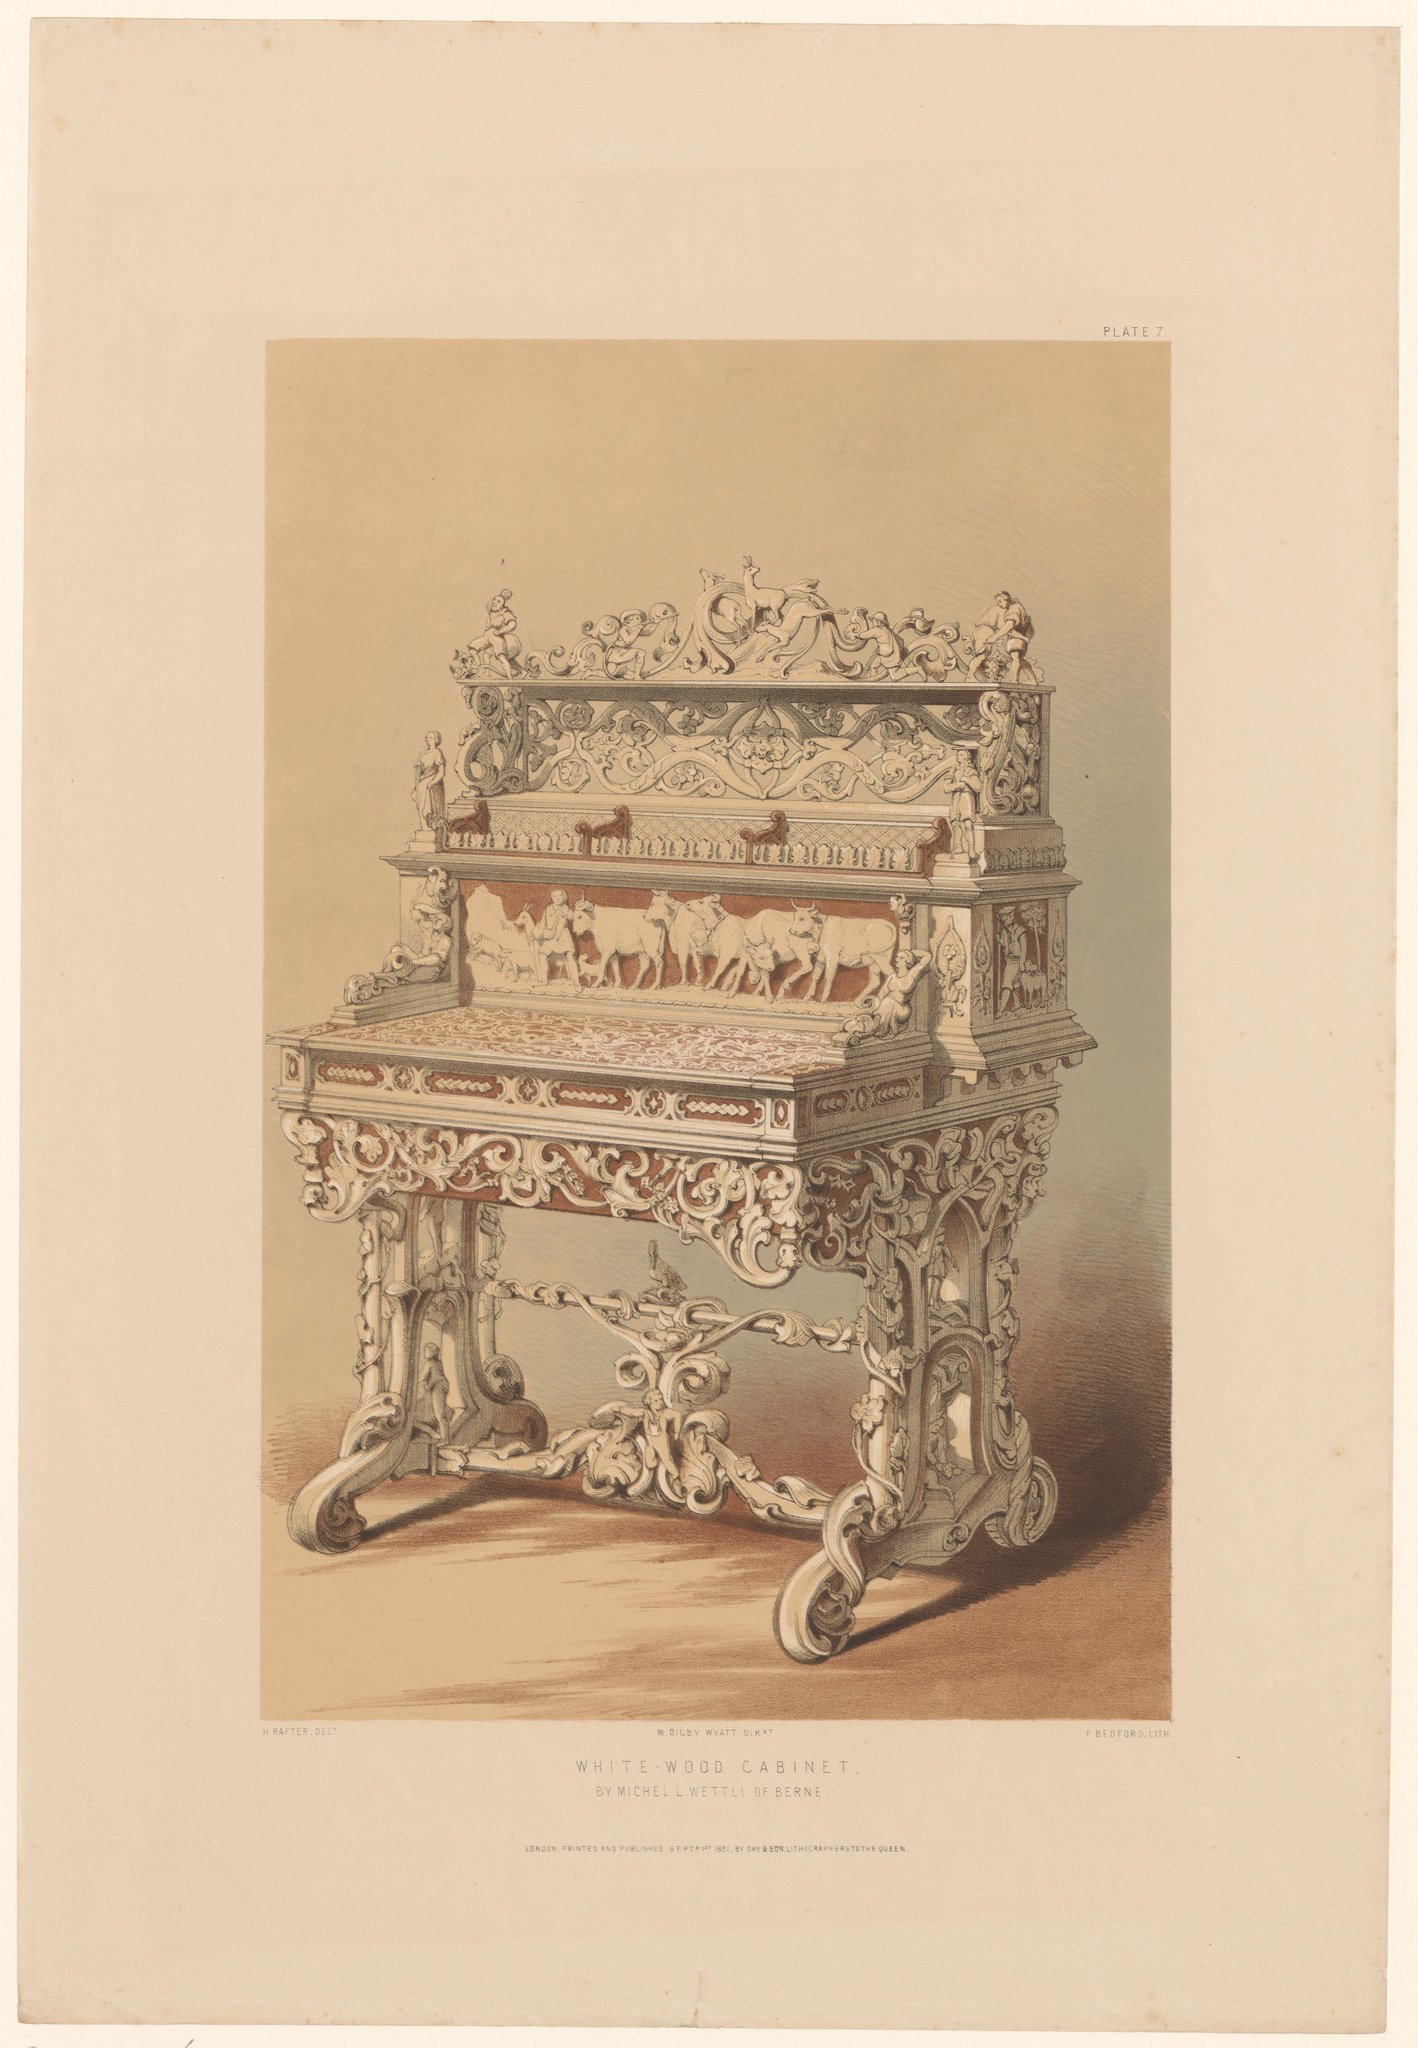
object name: print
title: White-wood cabinet, by Michell Wettli of Berne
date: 1851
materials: paper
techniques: lithograph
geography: london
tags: writing-table, writing-desk, decorative furniture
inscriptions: collector's mark: Lugt 2228